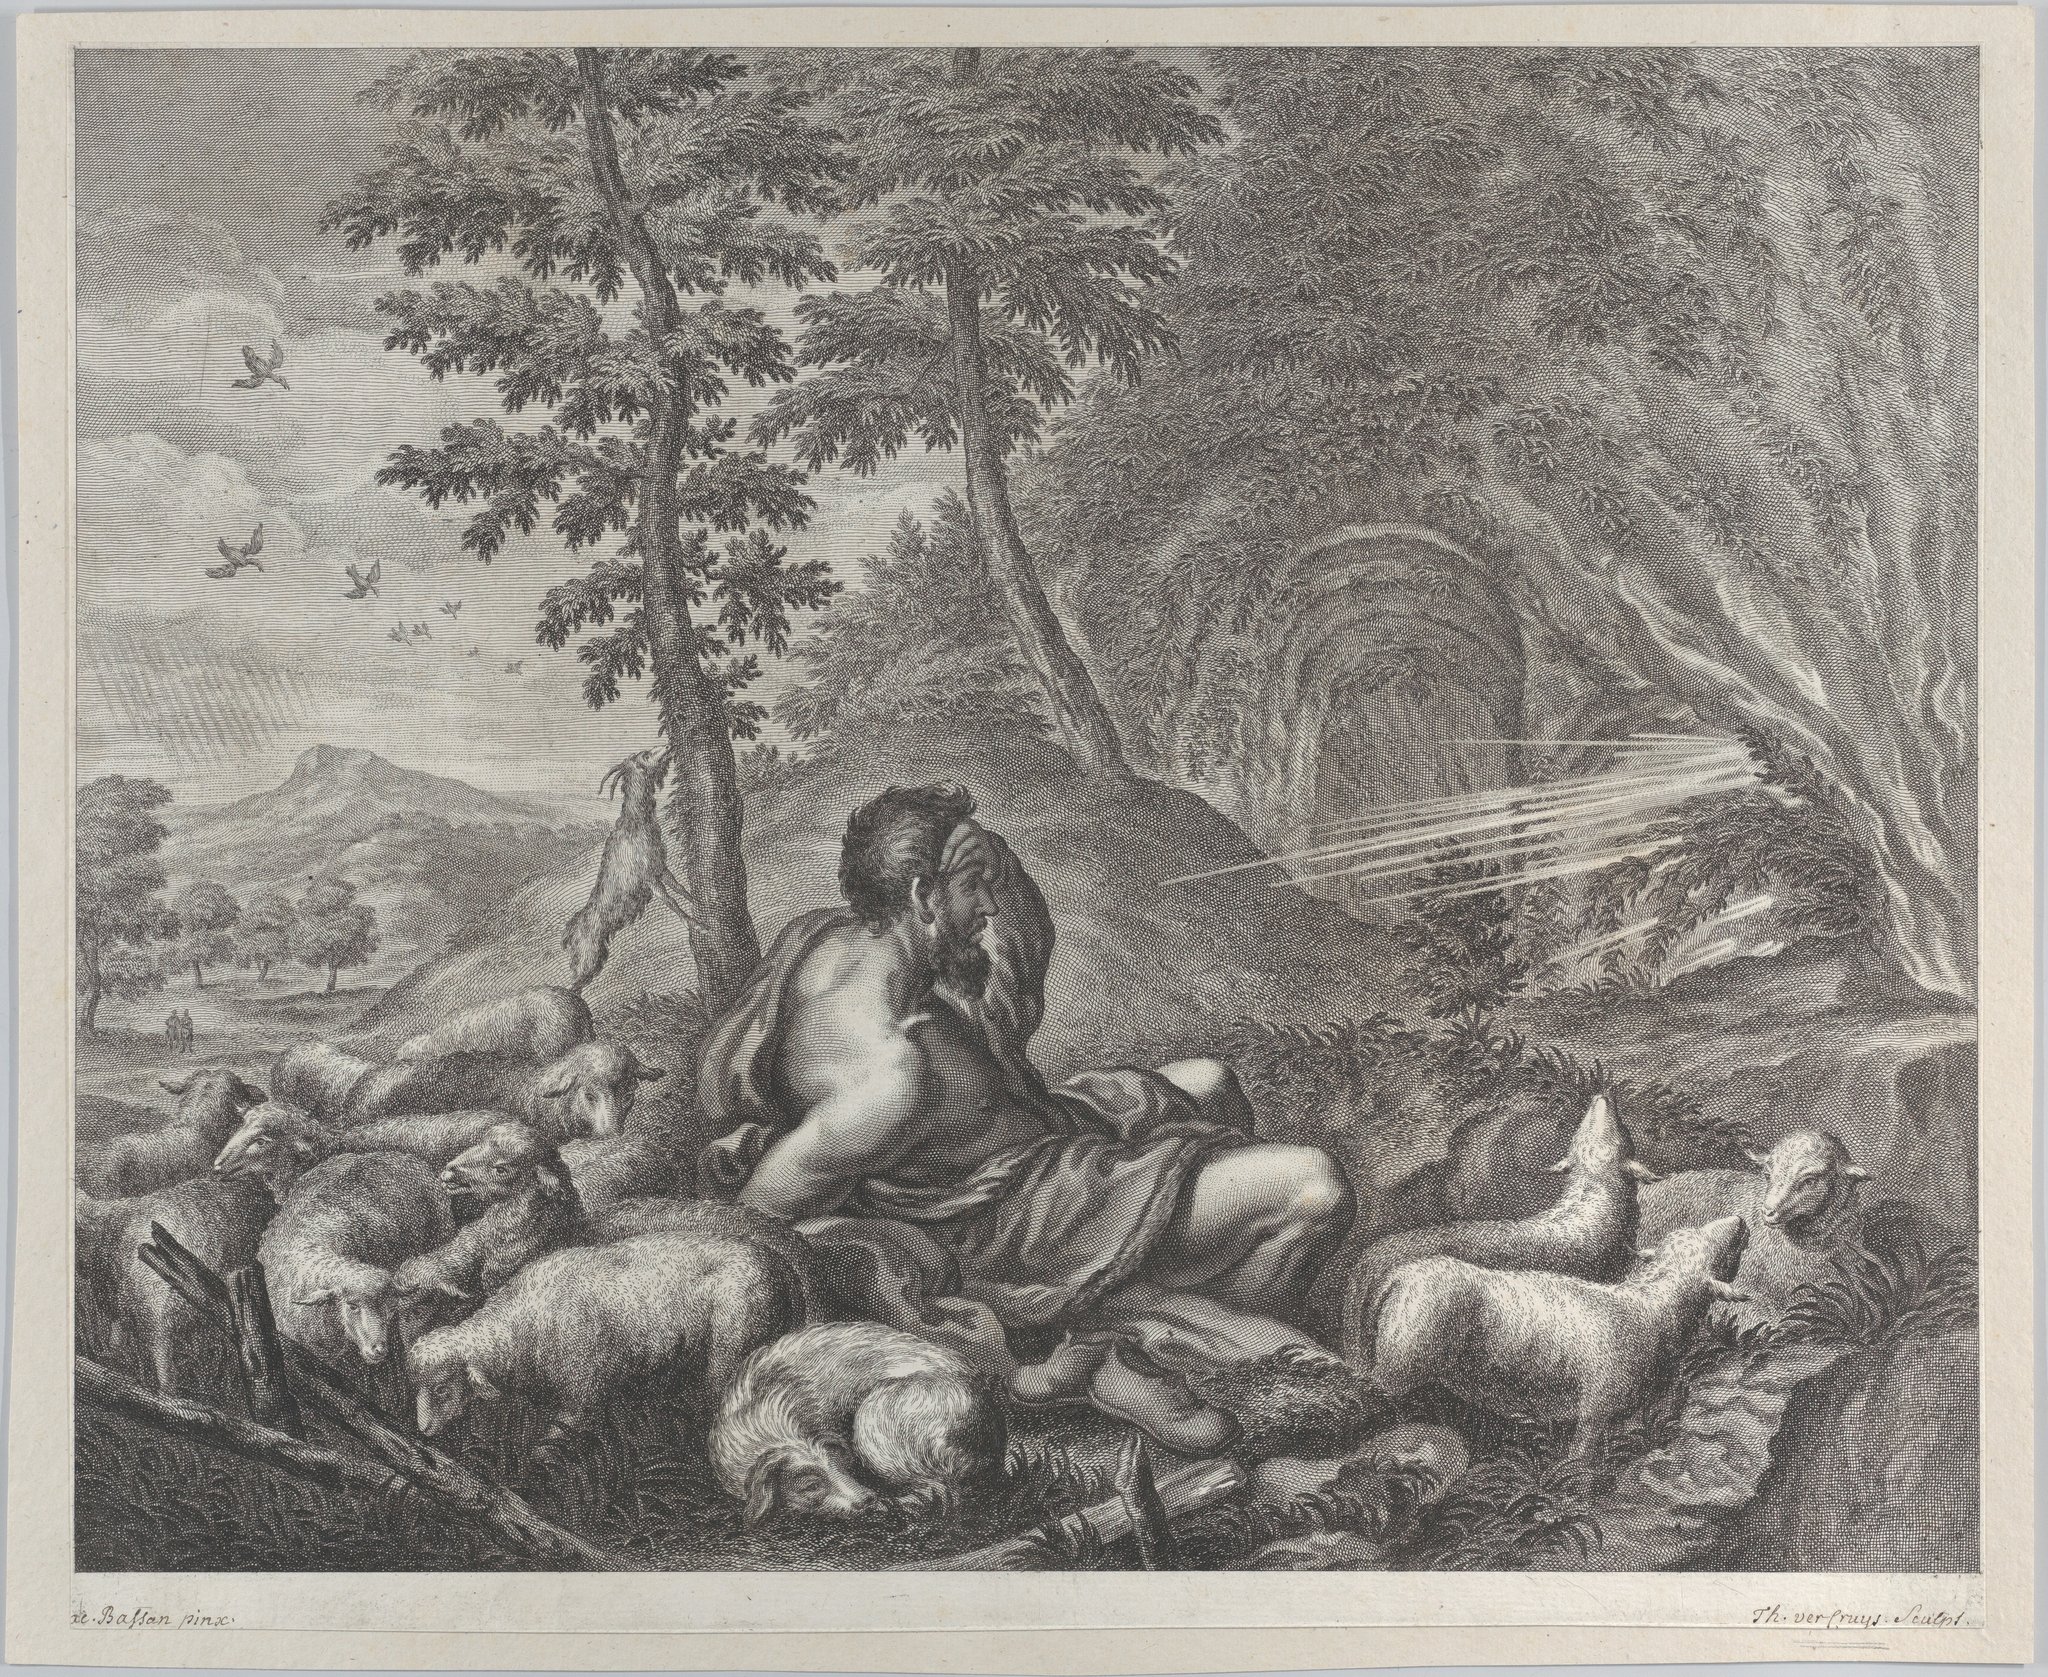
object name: print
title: Jacob guarding Laban's flock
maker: theodore cruger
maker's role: artist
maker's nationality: german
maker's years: 1613-1624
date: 1613-1624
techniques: engraving